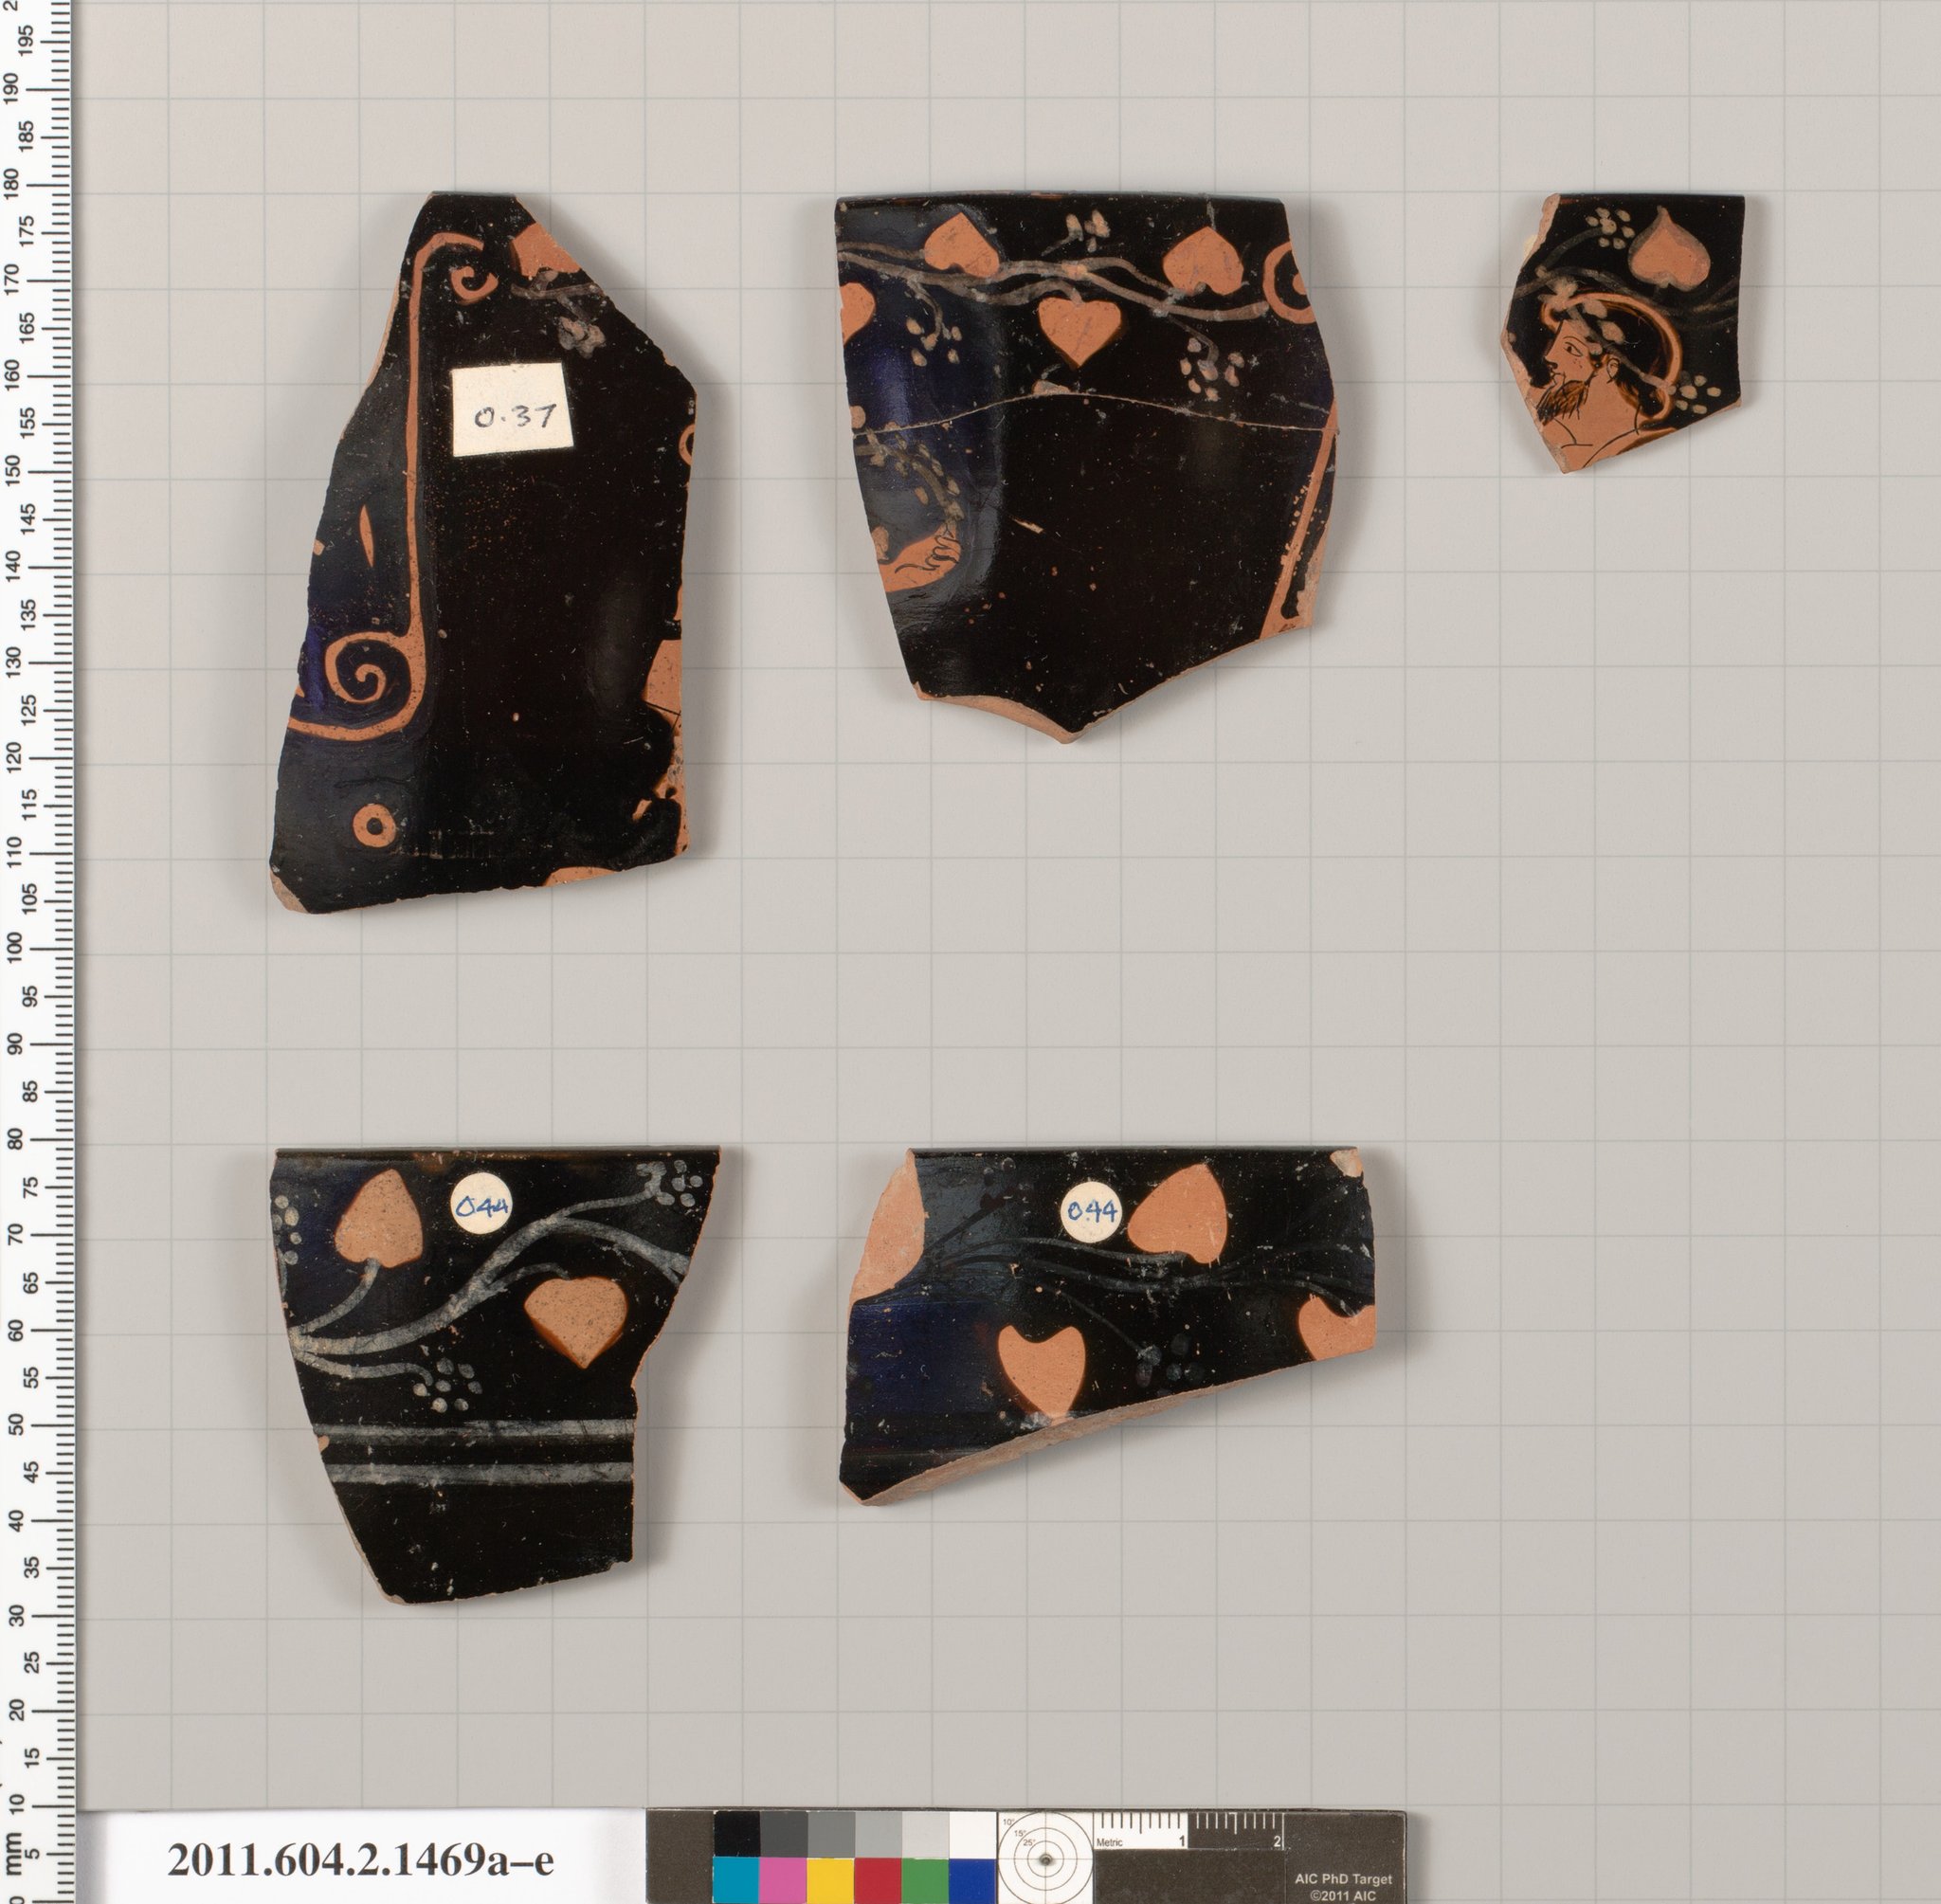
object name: skyphos fragment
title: Terracotta rim fragments of a skyphos (deep drinking cup)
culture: greek, attic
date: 490-470 BCE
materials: terracotta